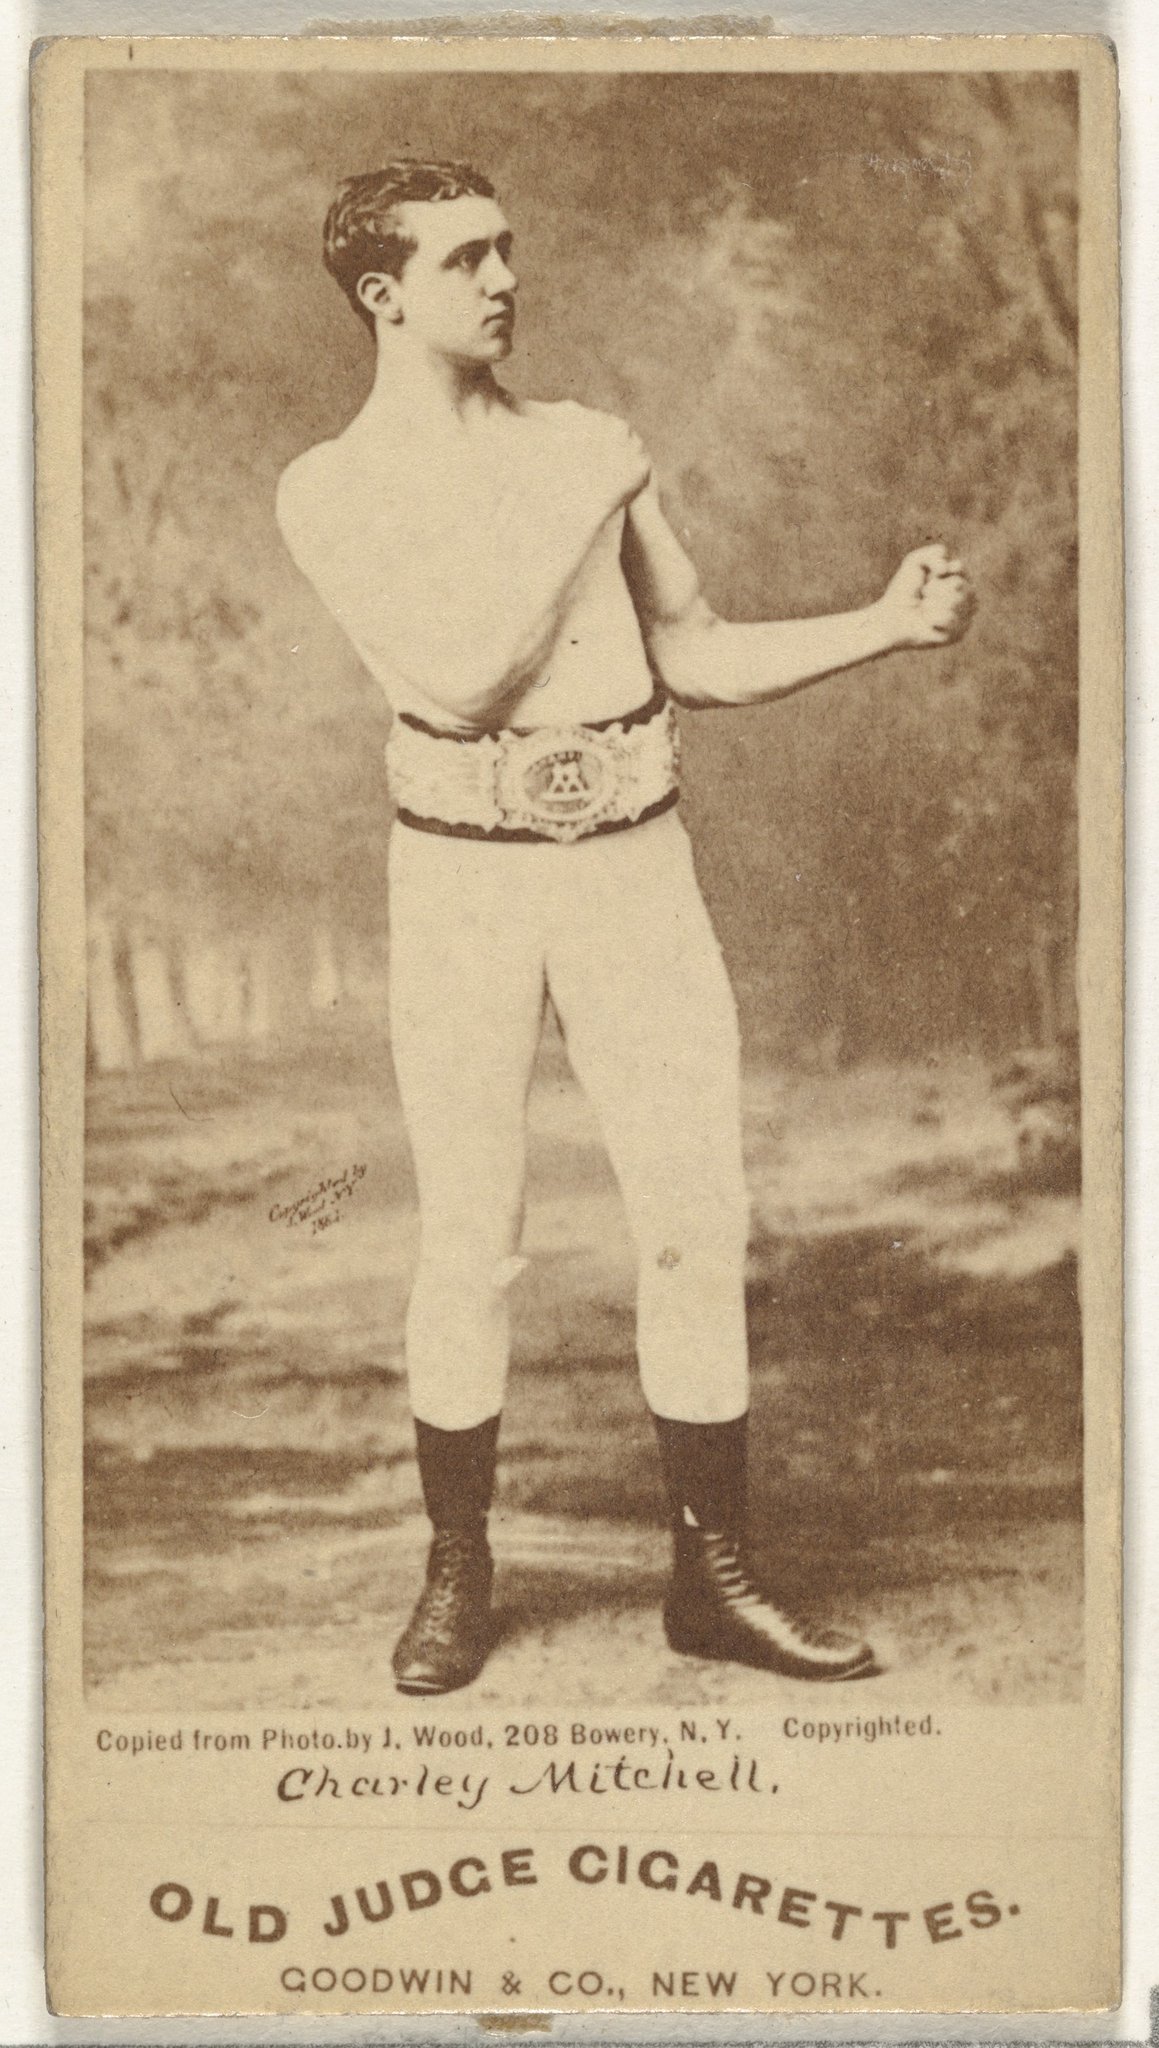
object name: photograph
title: Charley Mitchell, from the Celebrities and Prizefighters series (N174) for Old Judge Cigarettes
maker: goodwin & company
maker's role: publisher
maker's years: 1850-1950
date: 1887-1888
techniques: albumen silver print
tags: men,portraits,baseball,athletes